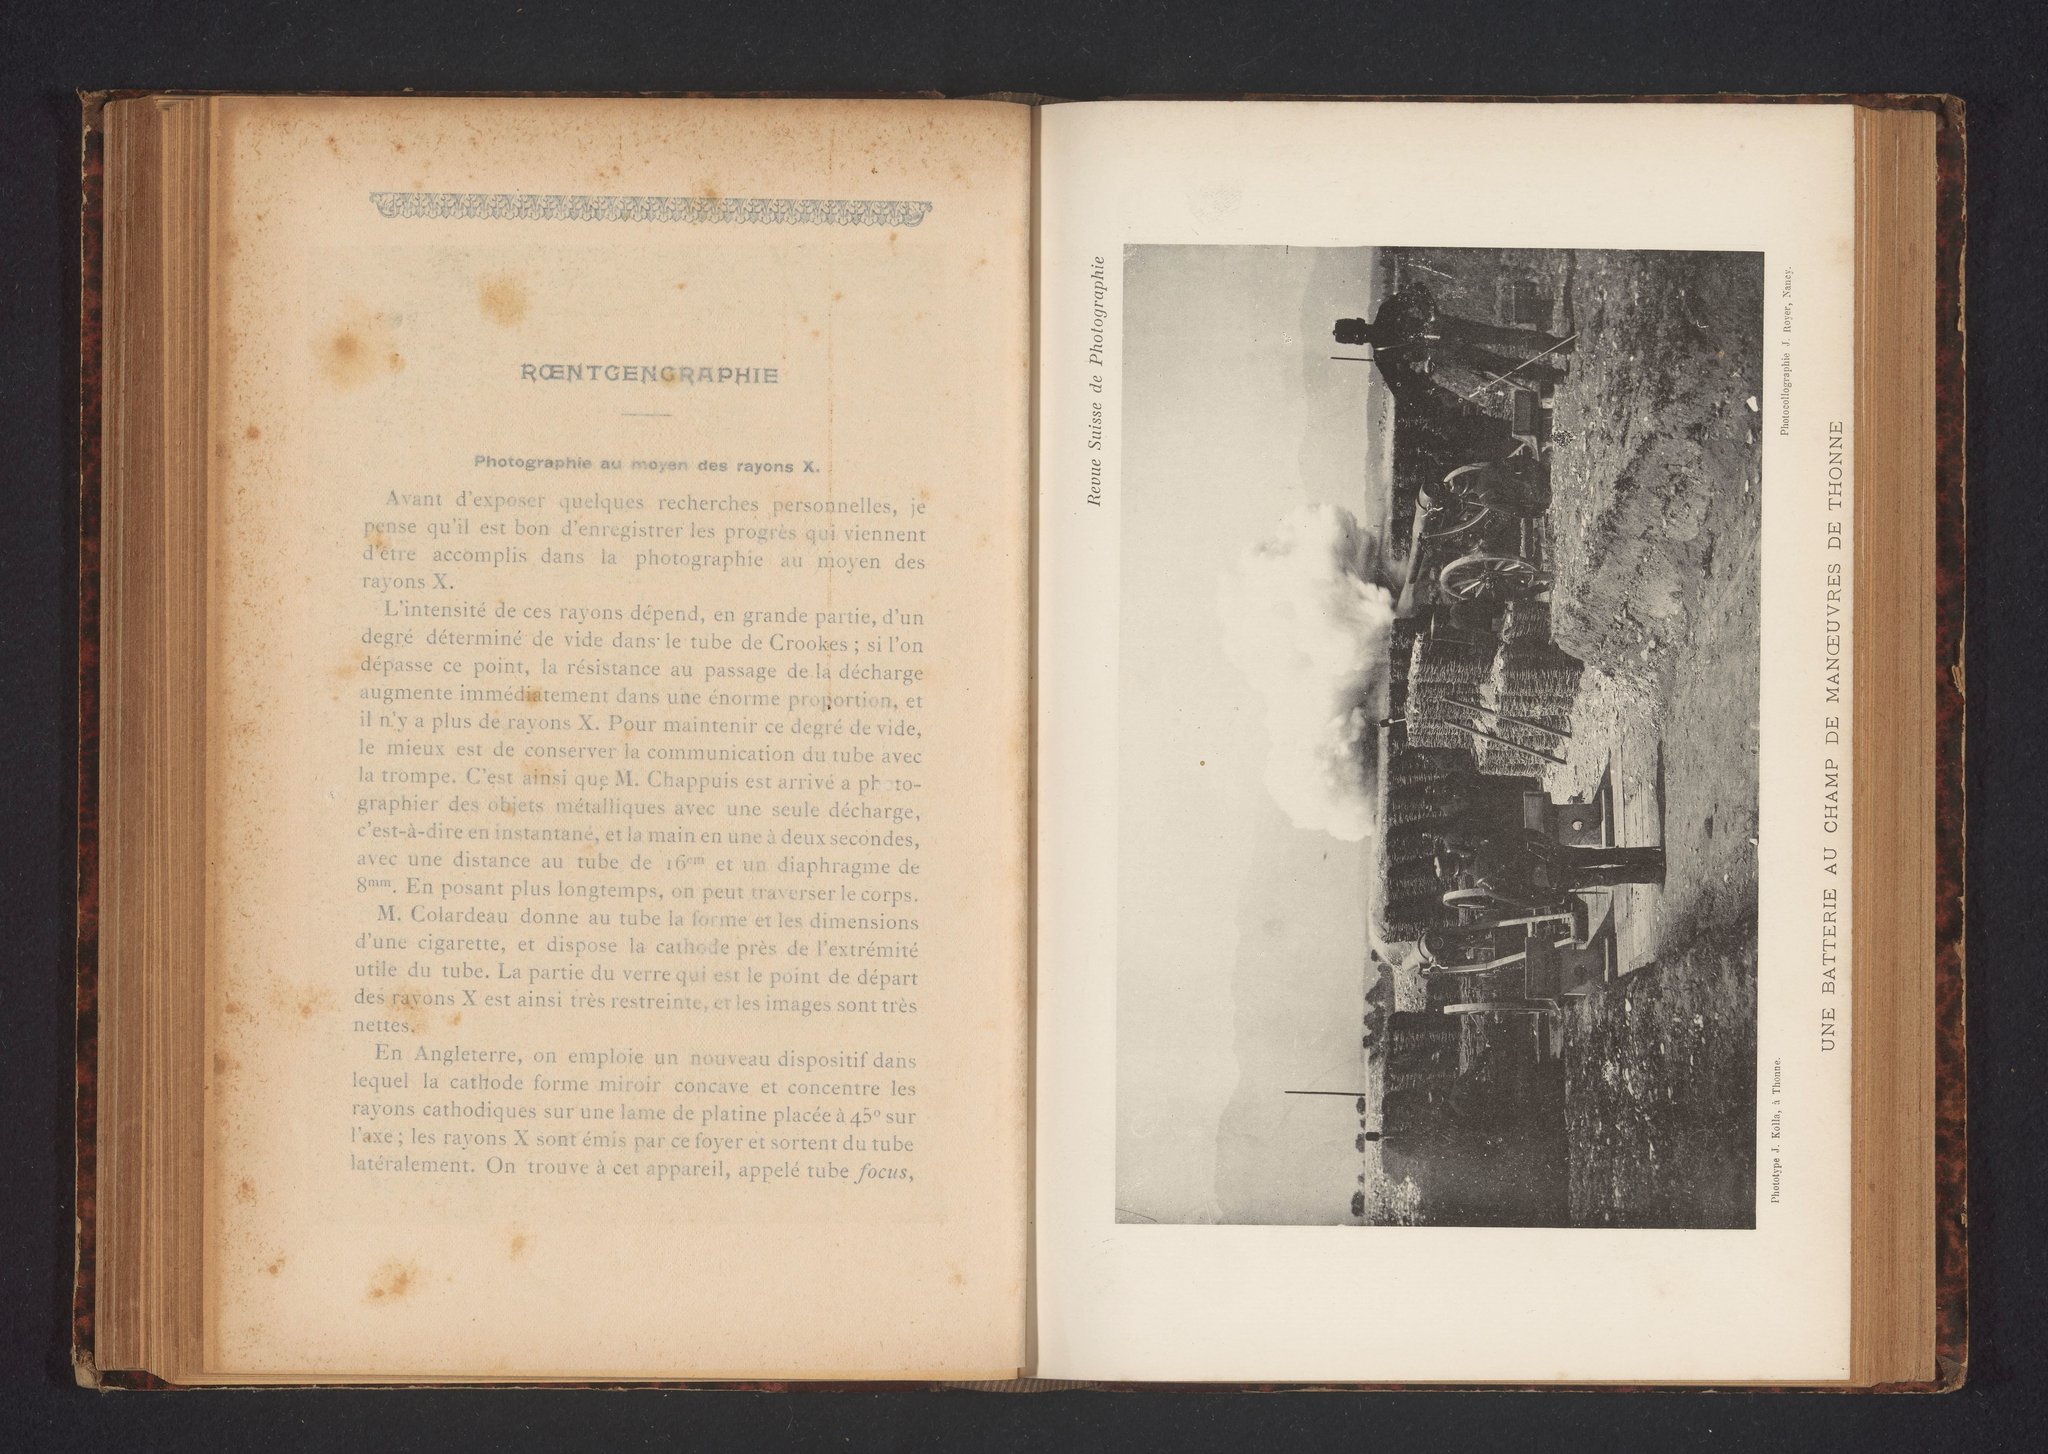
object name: photomechanical print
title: Twee kanonniers bij Thonne, Frankrijk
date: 1891-1896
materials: paper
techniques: photograph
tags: firearms: cannon